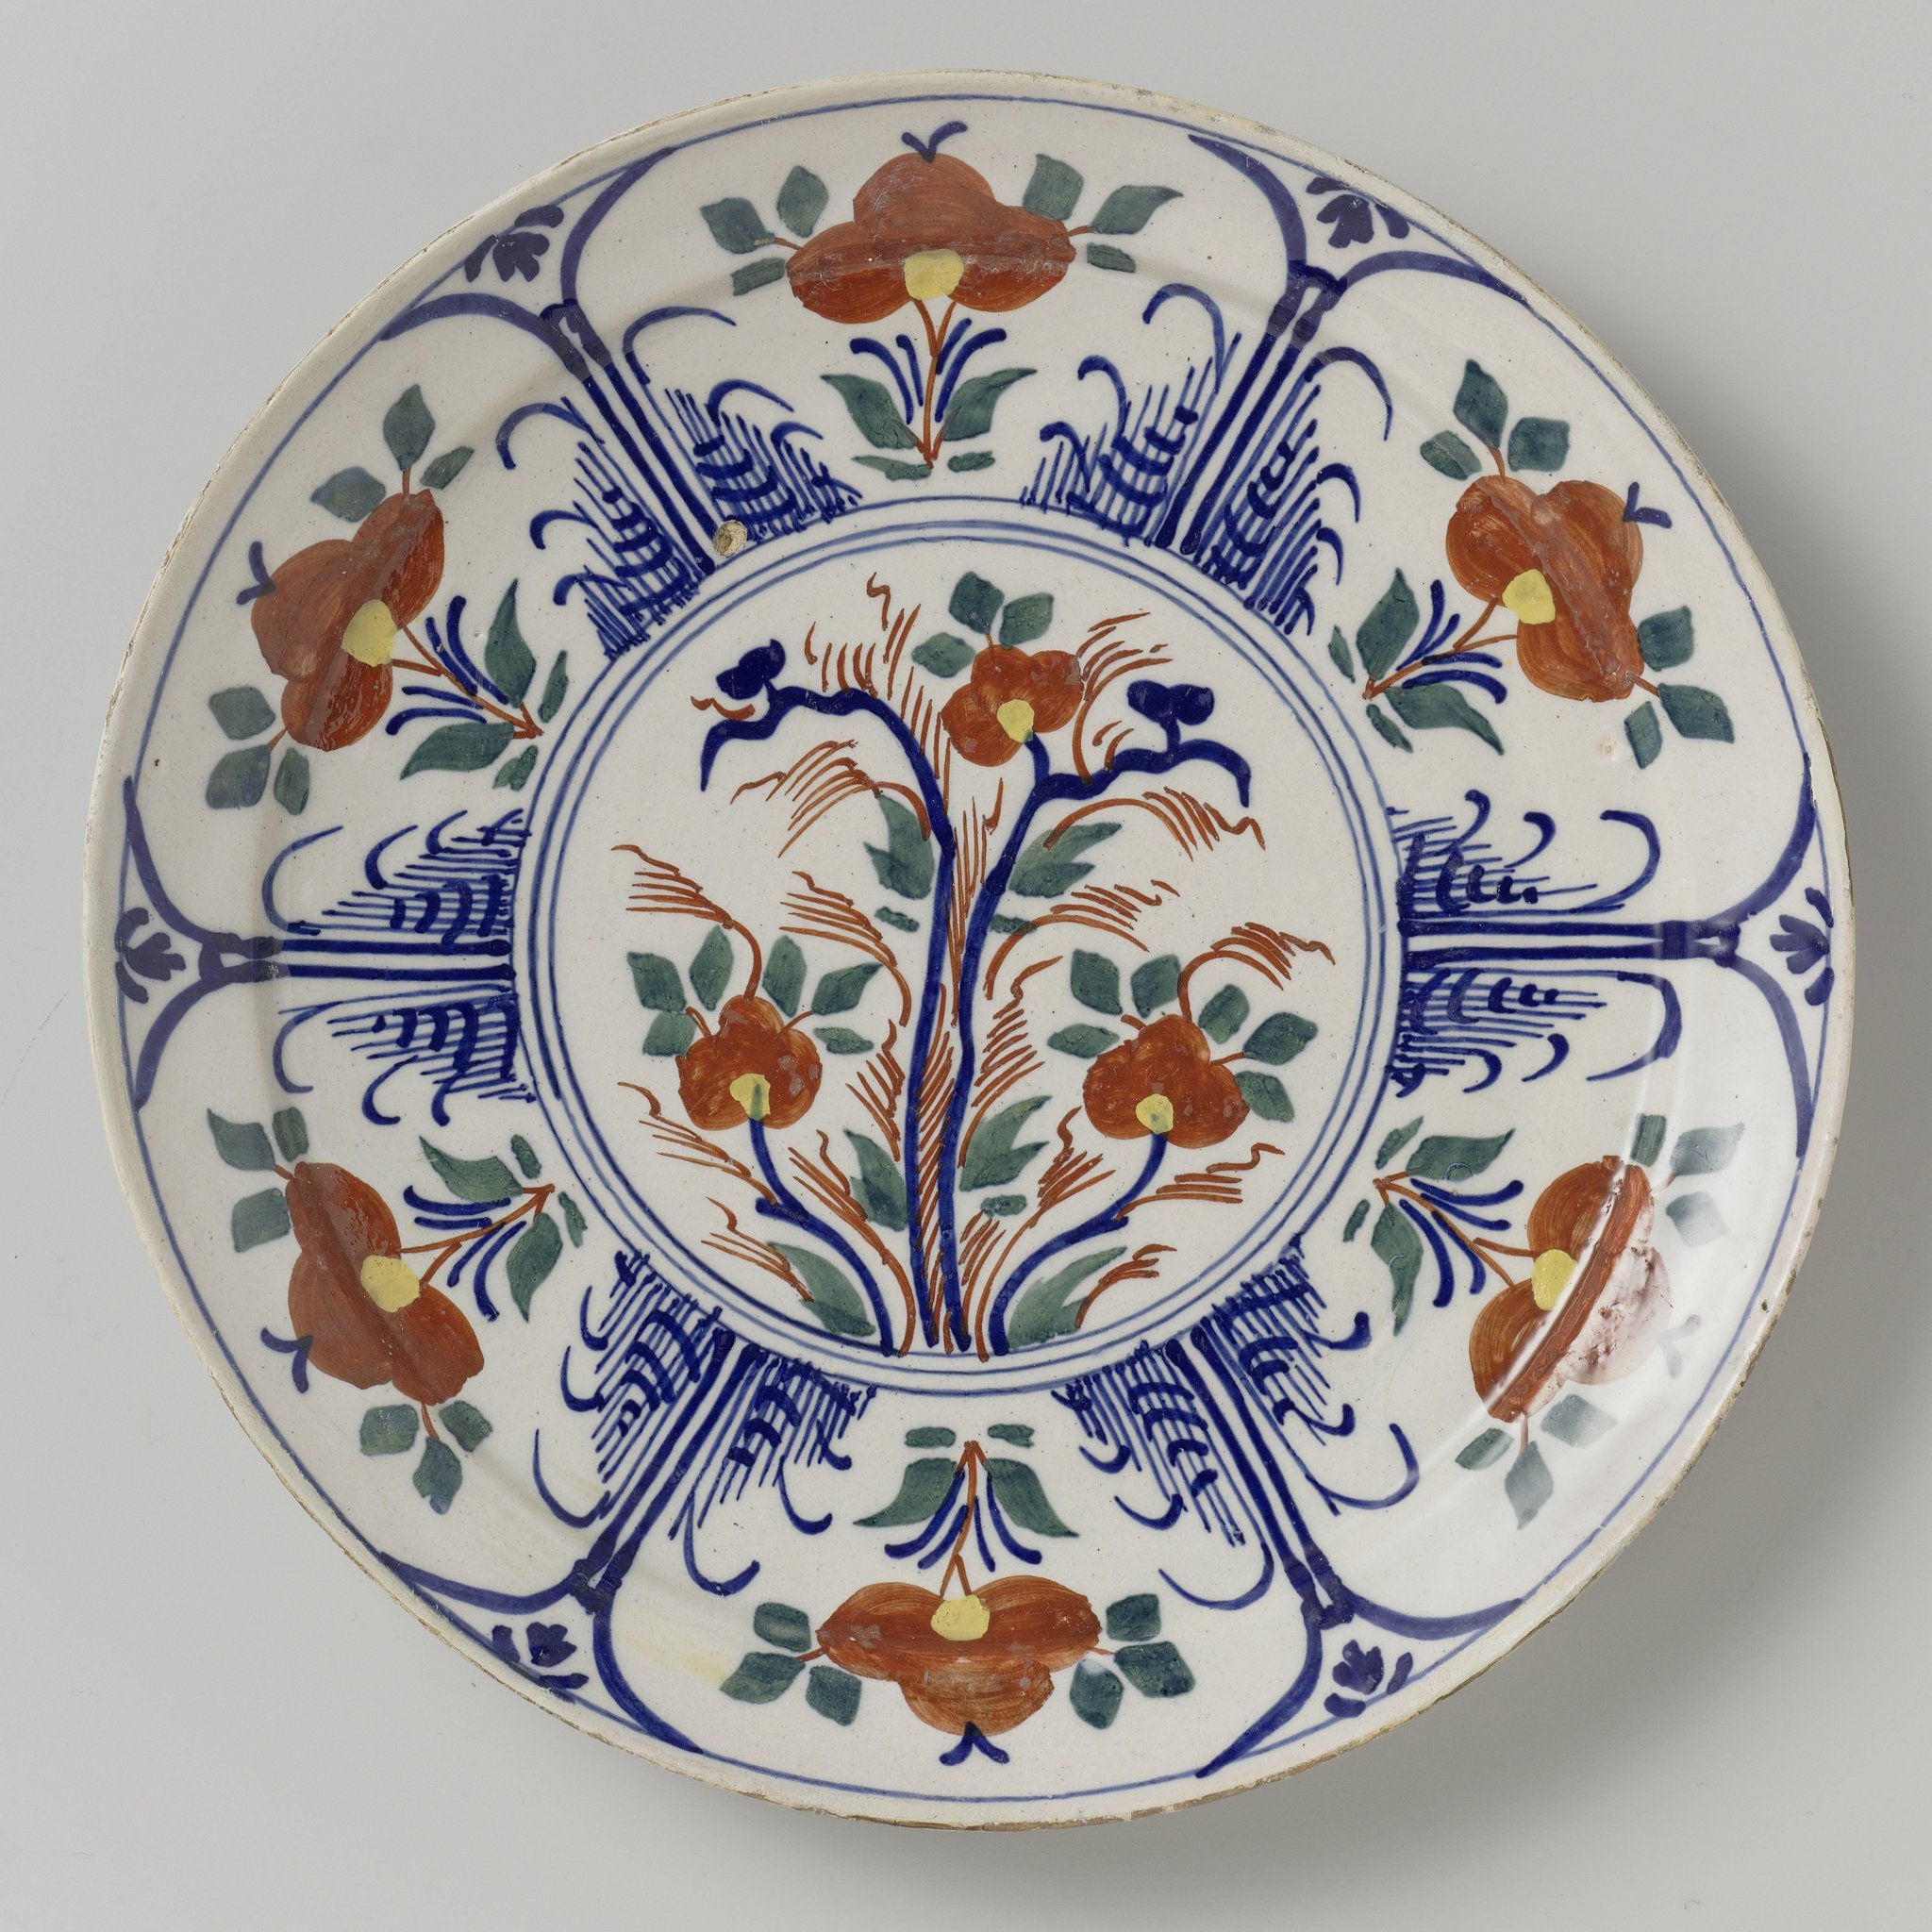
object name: plate dish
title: bord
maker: Anonymous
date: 1740-1780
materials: earthenware, glaze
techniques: painted, polychromy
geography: delft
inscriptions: collector's mark: ‘collection/ Joseph M. Morpurgo/ antiquair/ Nieuwe Hoogstraat 7/ Amsterdam/ Garanti Ancien’, seal: ‘N 2780/ 2 stuks/ VOX’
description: Rond bord van veelkleurig beschilderde faience, met in het midden een cirkel met daarin bloemen in de kleuren groen, blauw en rood. Rond de cirkel zijn zes vakken met daarin bloemen in de kleuren groen, blauw en rood. Bij het bord hoort een identiek bord met het invnr. BK-KOG-2433-a.